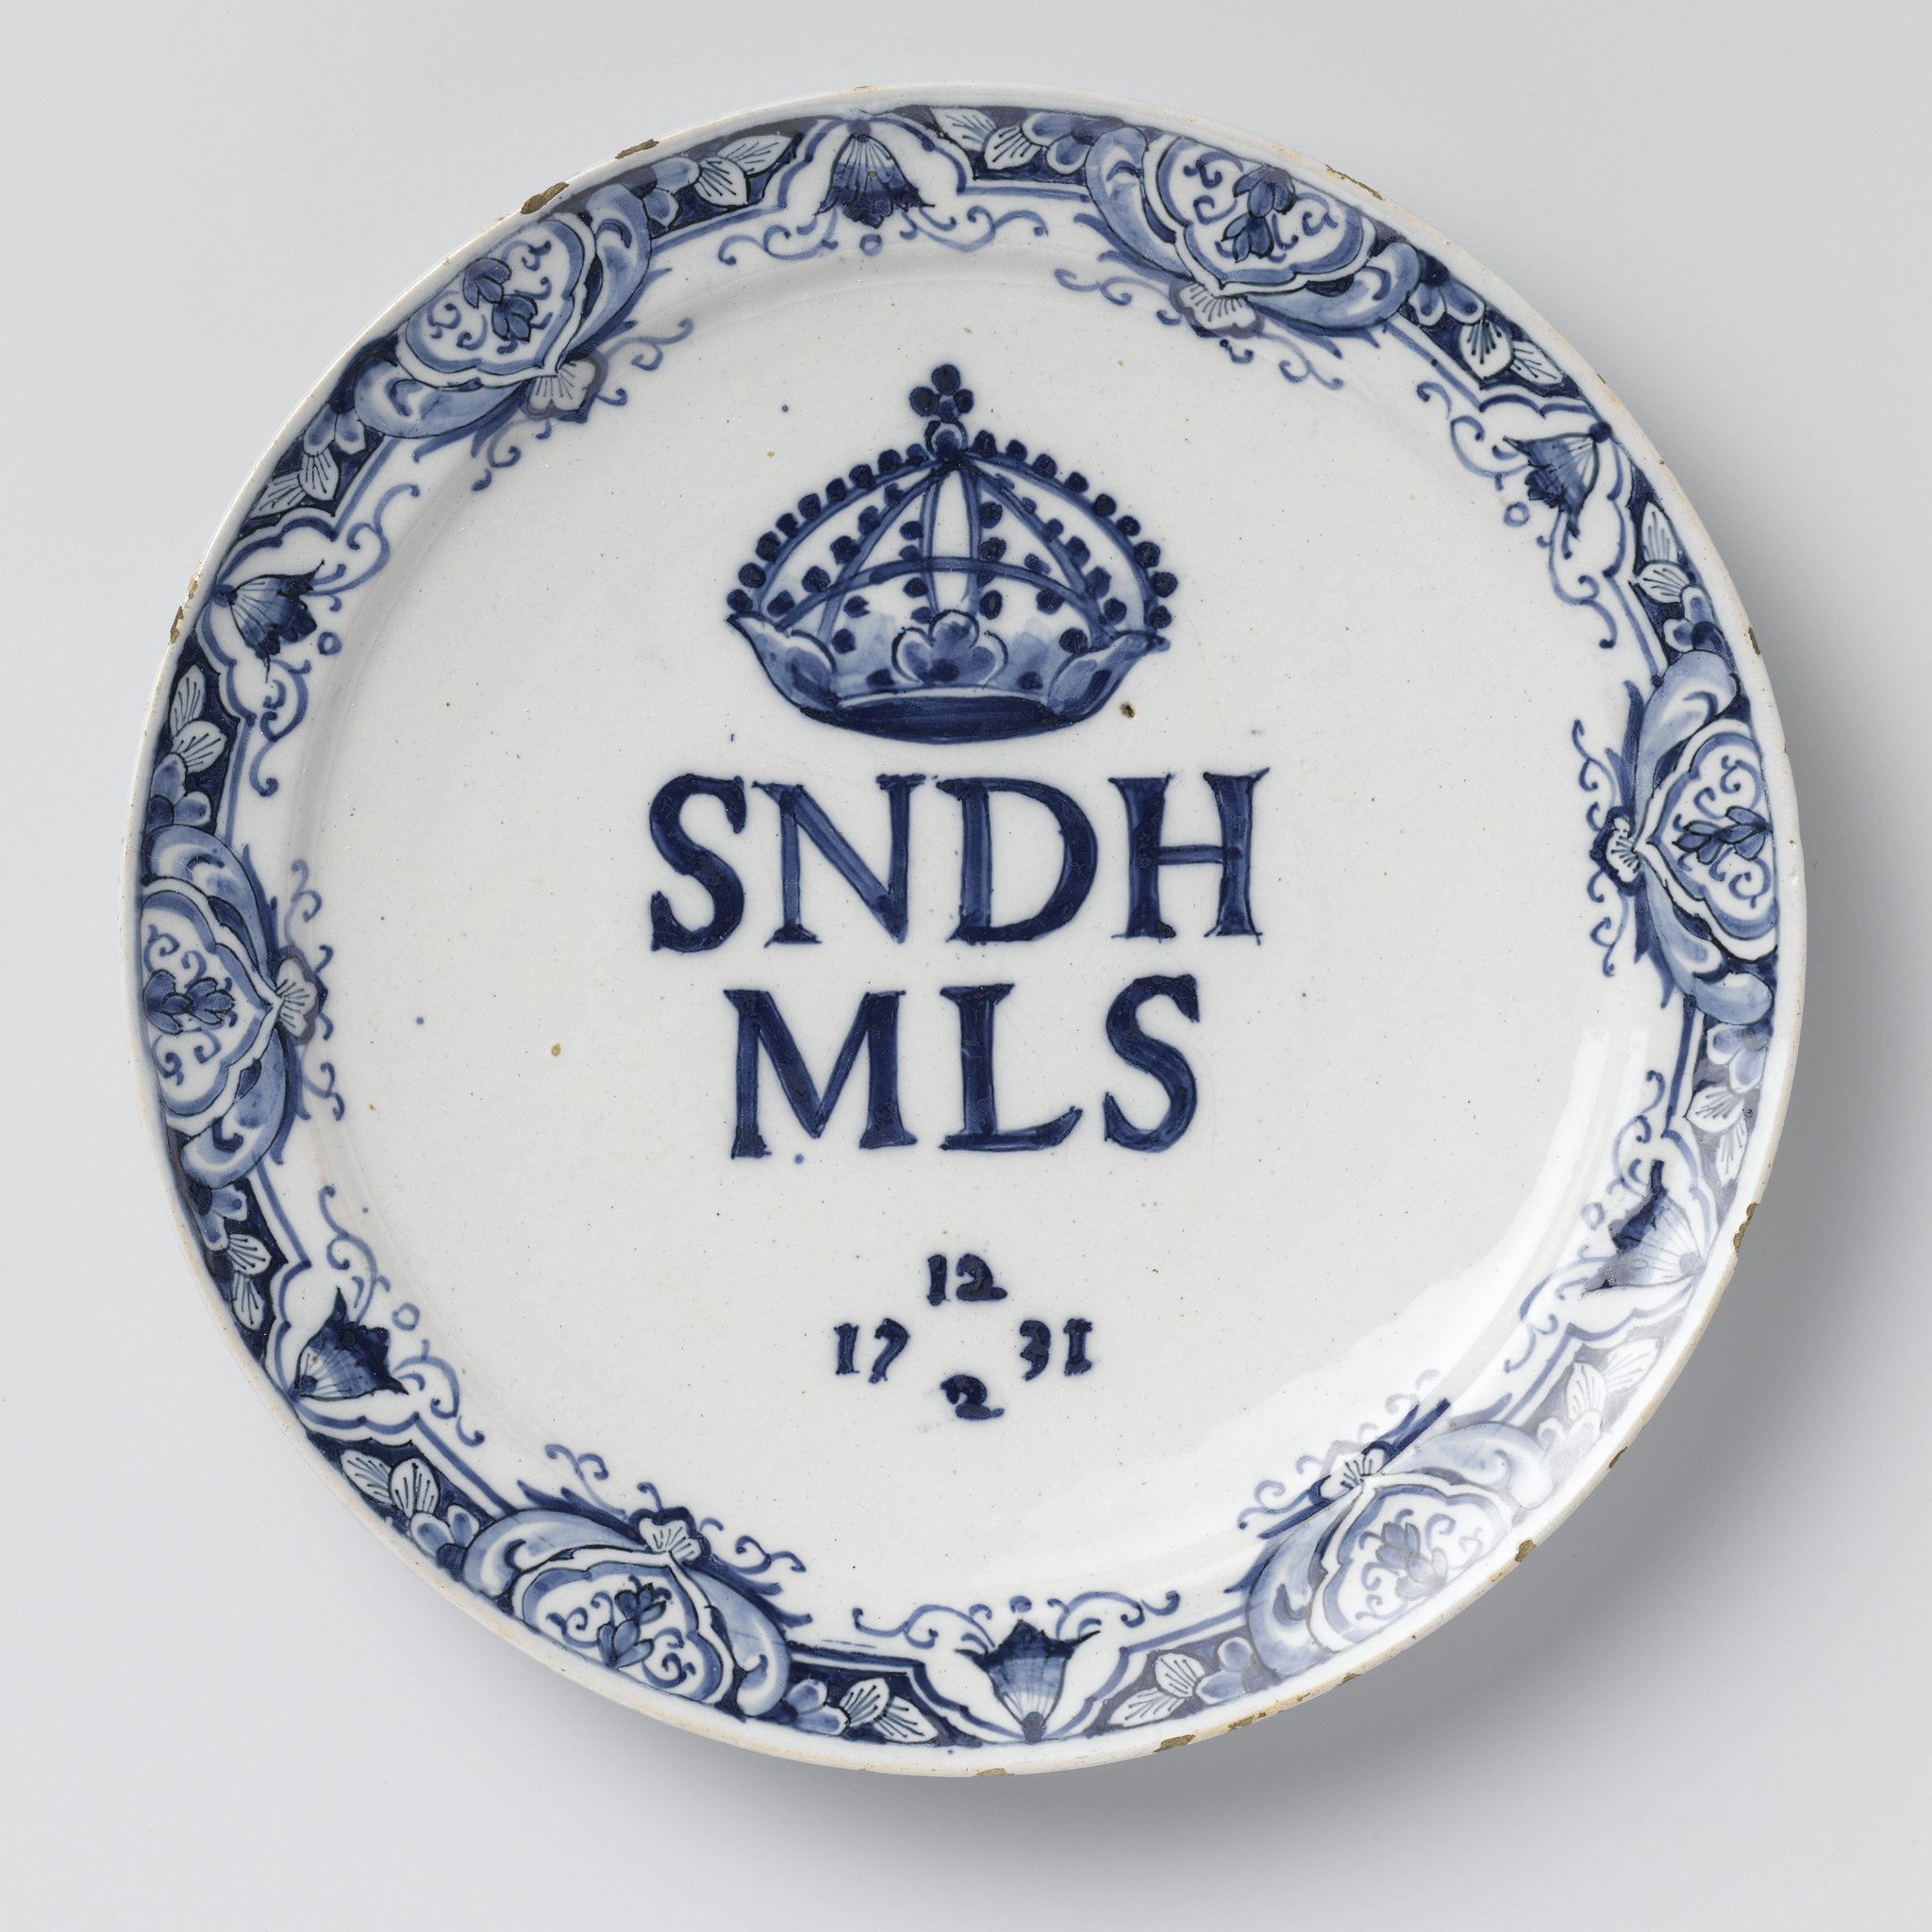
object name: plate dish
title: Bord, beschilderd met een twee onbekende monogrammen onder een kroon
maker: Anonymous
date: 1731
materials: earthenware, glaze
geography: delft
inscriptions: inscription: ‘MVB(ineen)’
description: Bord van faience, beschilder in blauw met twee onbekende monogrammen, SNDH en MLS, onder een gefantaseerde koningskroon.